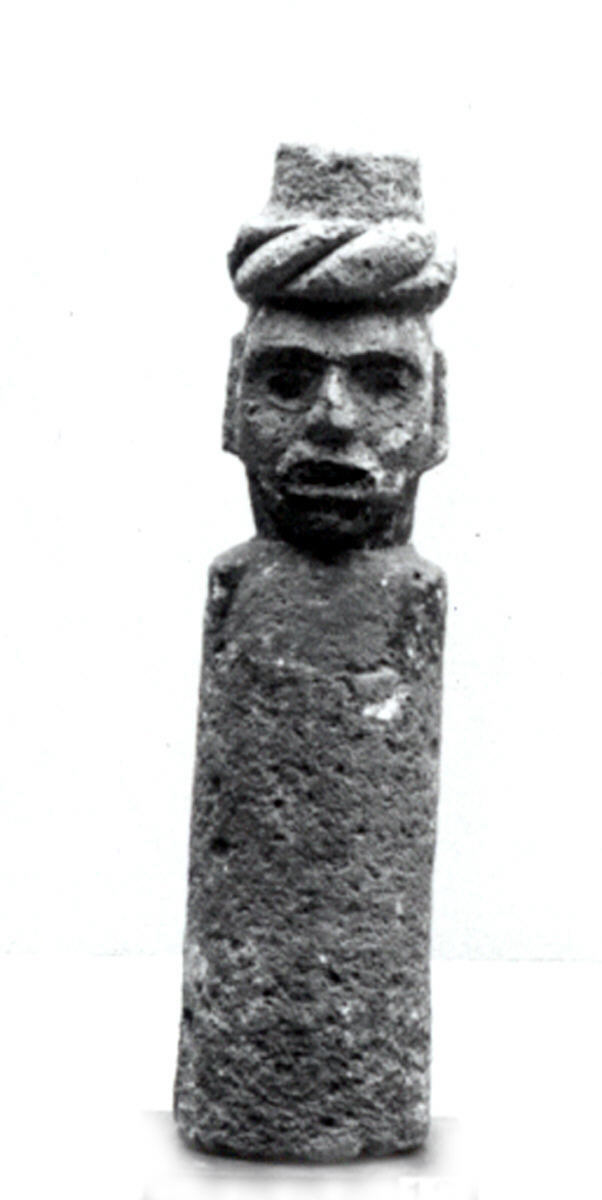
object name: figure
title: Stylized figure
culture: oaxaca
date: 501-1000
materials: stone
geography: mexico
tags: human figures